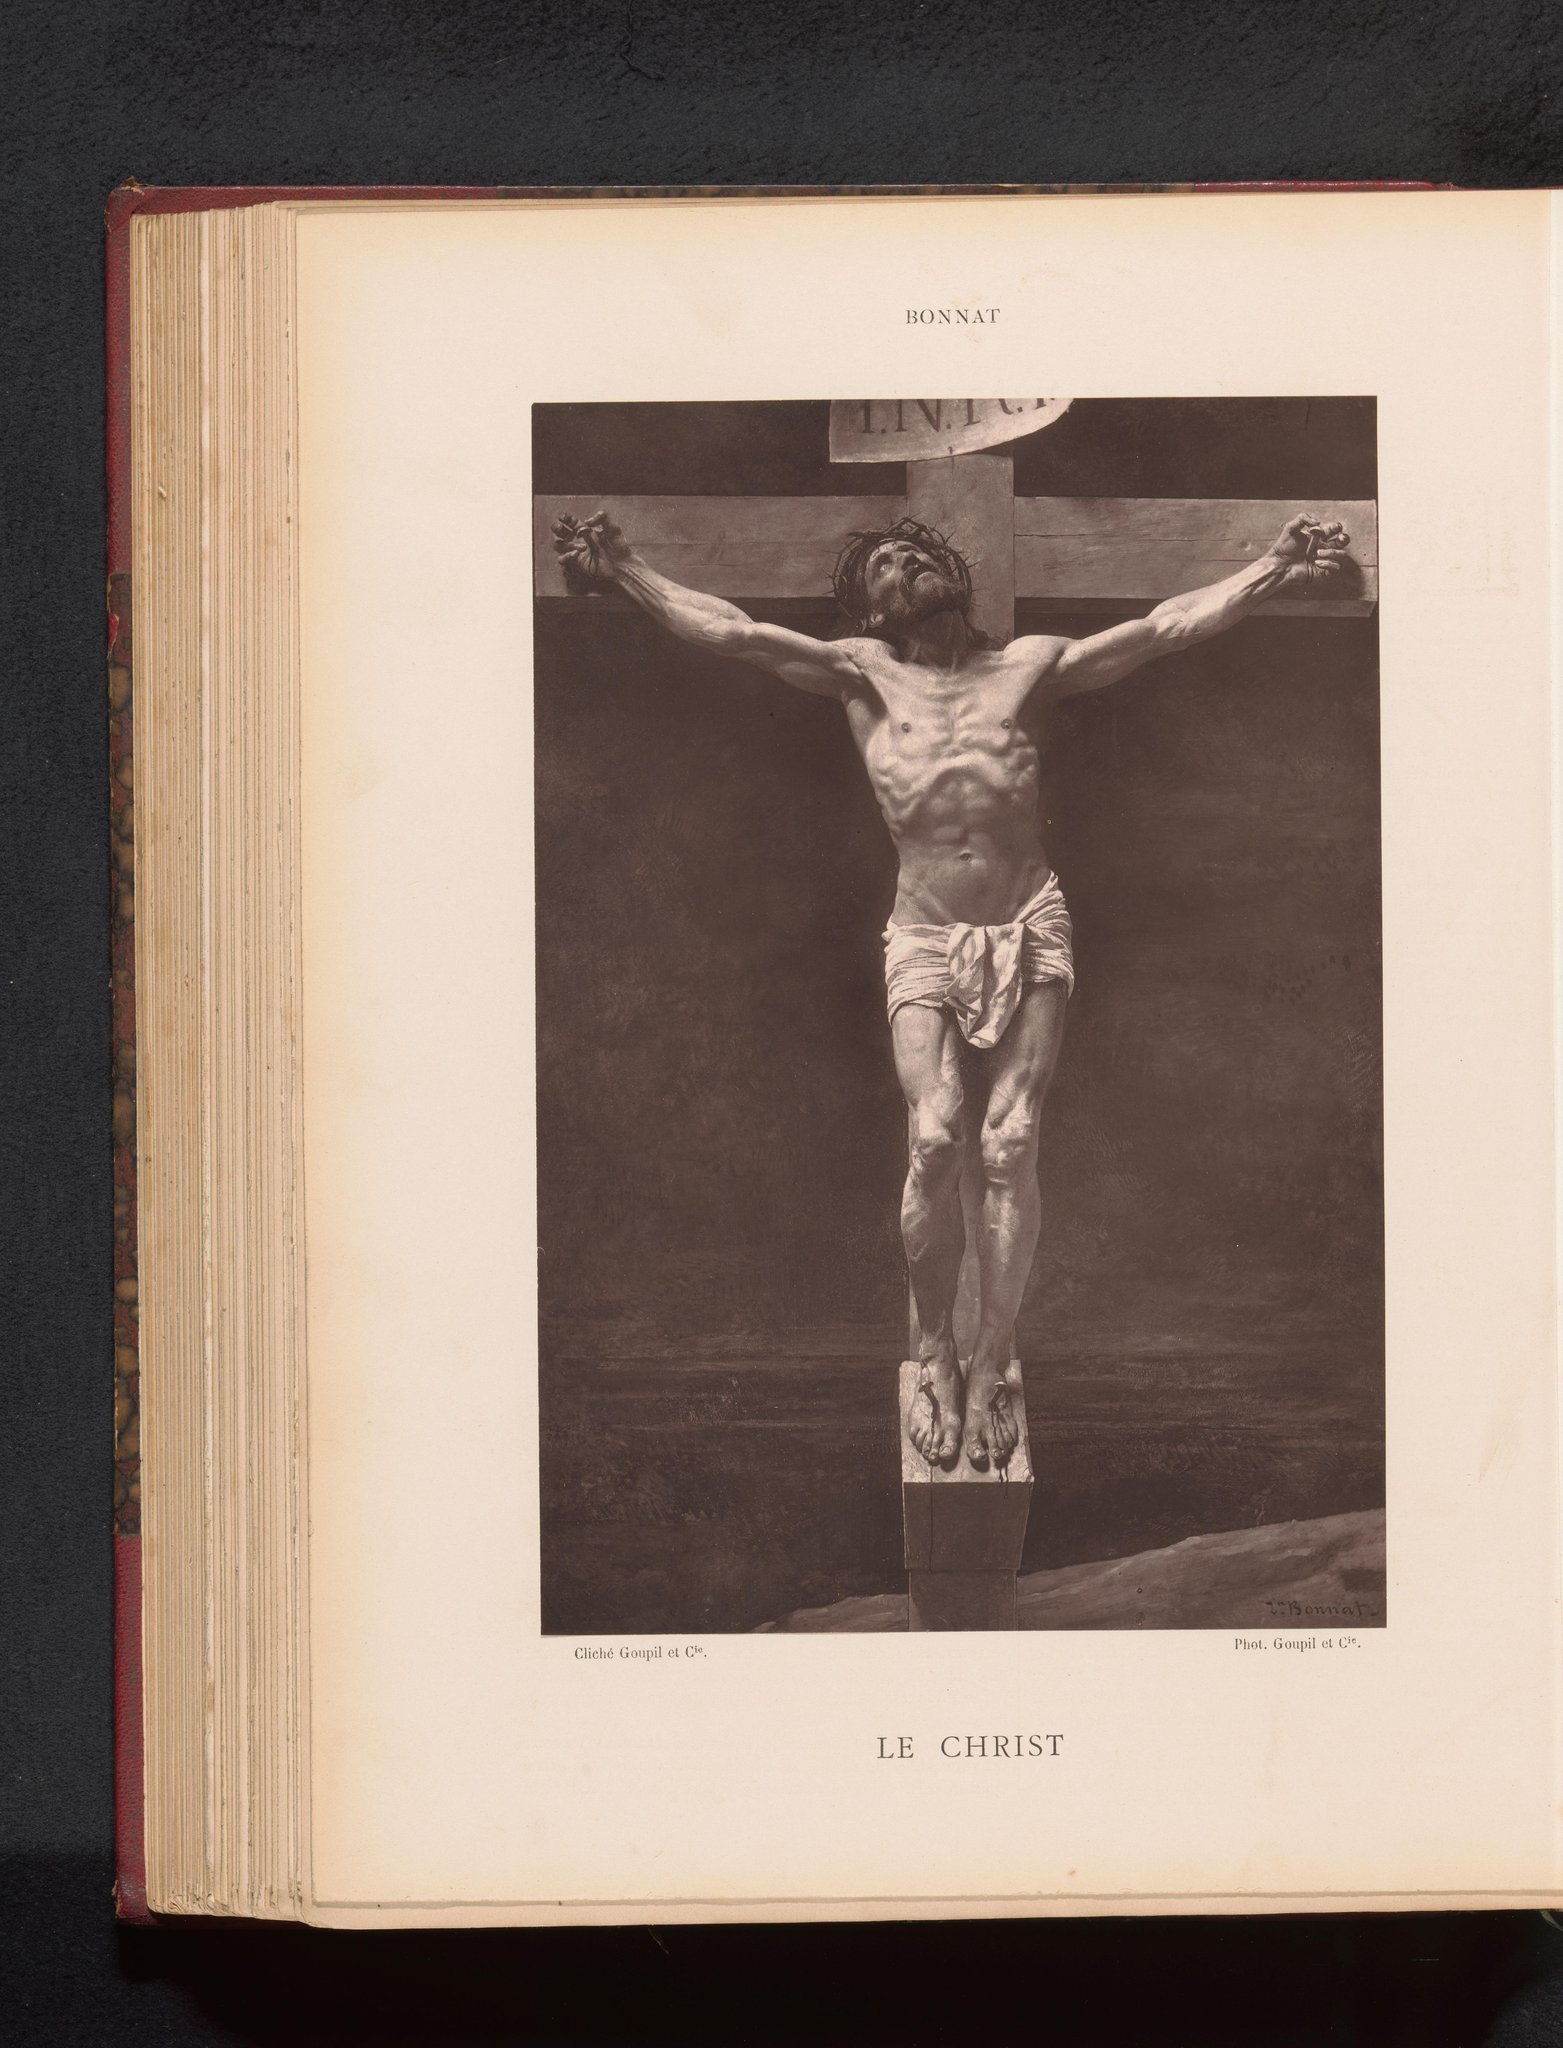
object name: photomechanical print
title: Reproductie van Le Christ door Léon Bonnat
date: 1867-1880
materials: paper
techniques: woodburytype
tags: specific types of crucified christ (in non-narrative context), painting, drawing and the graphic arts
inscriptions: inscription: ‘Bonnat’